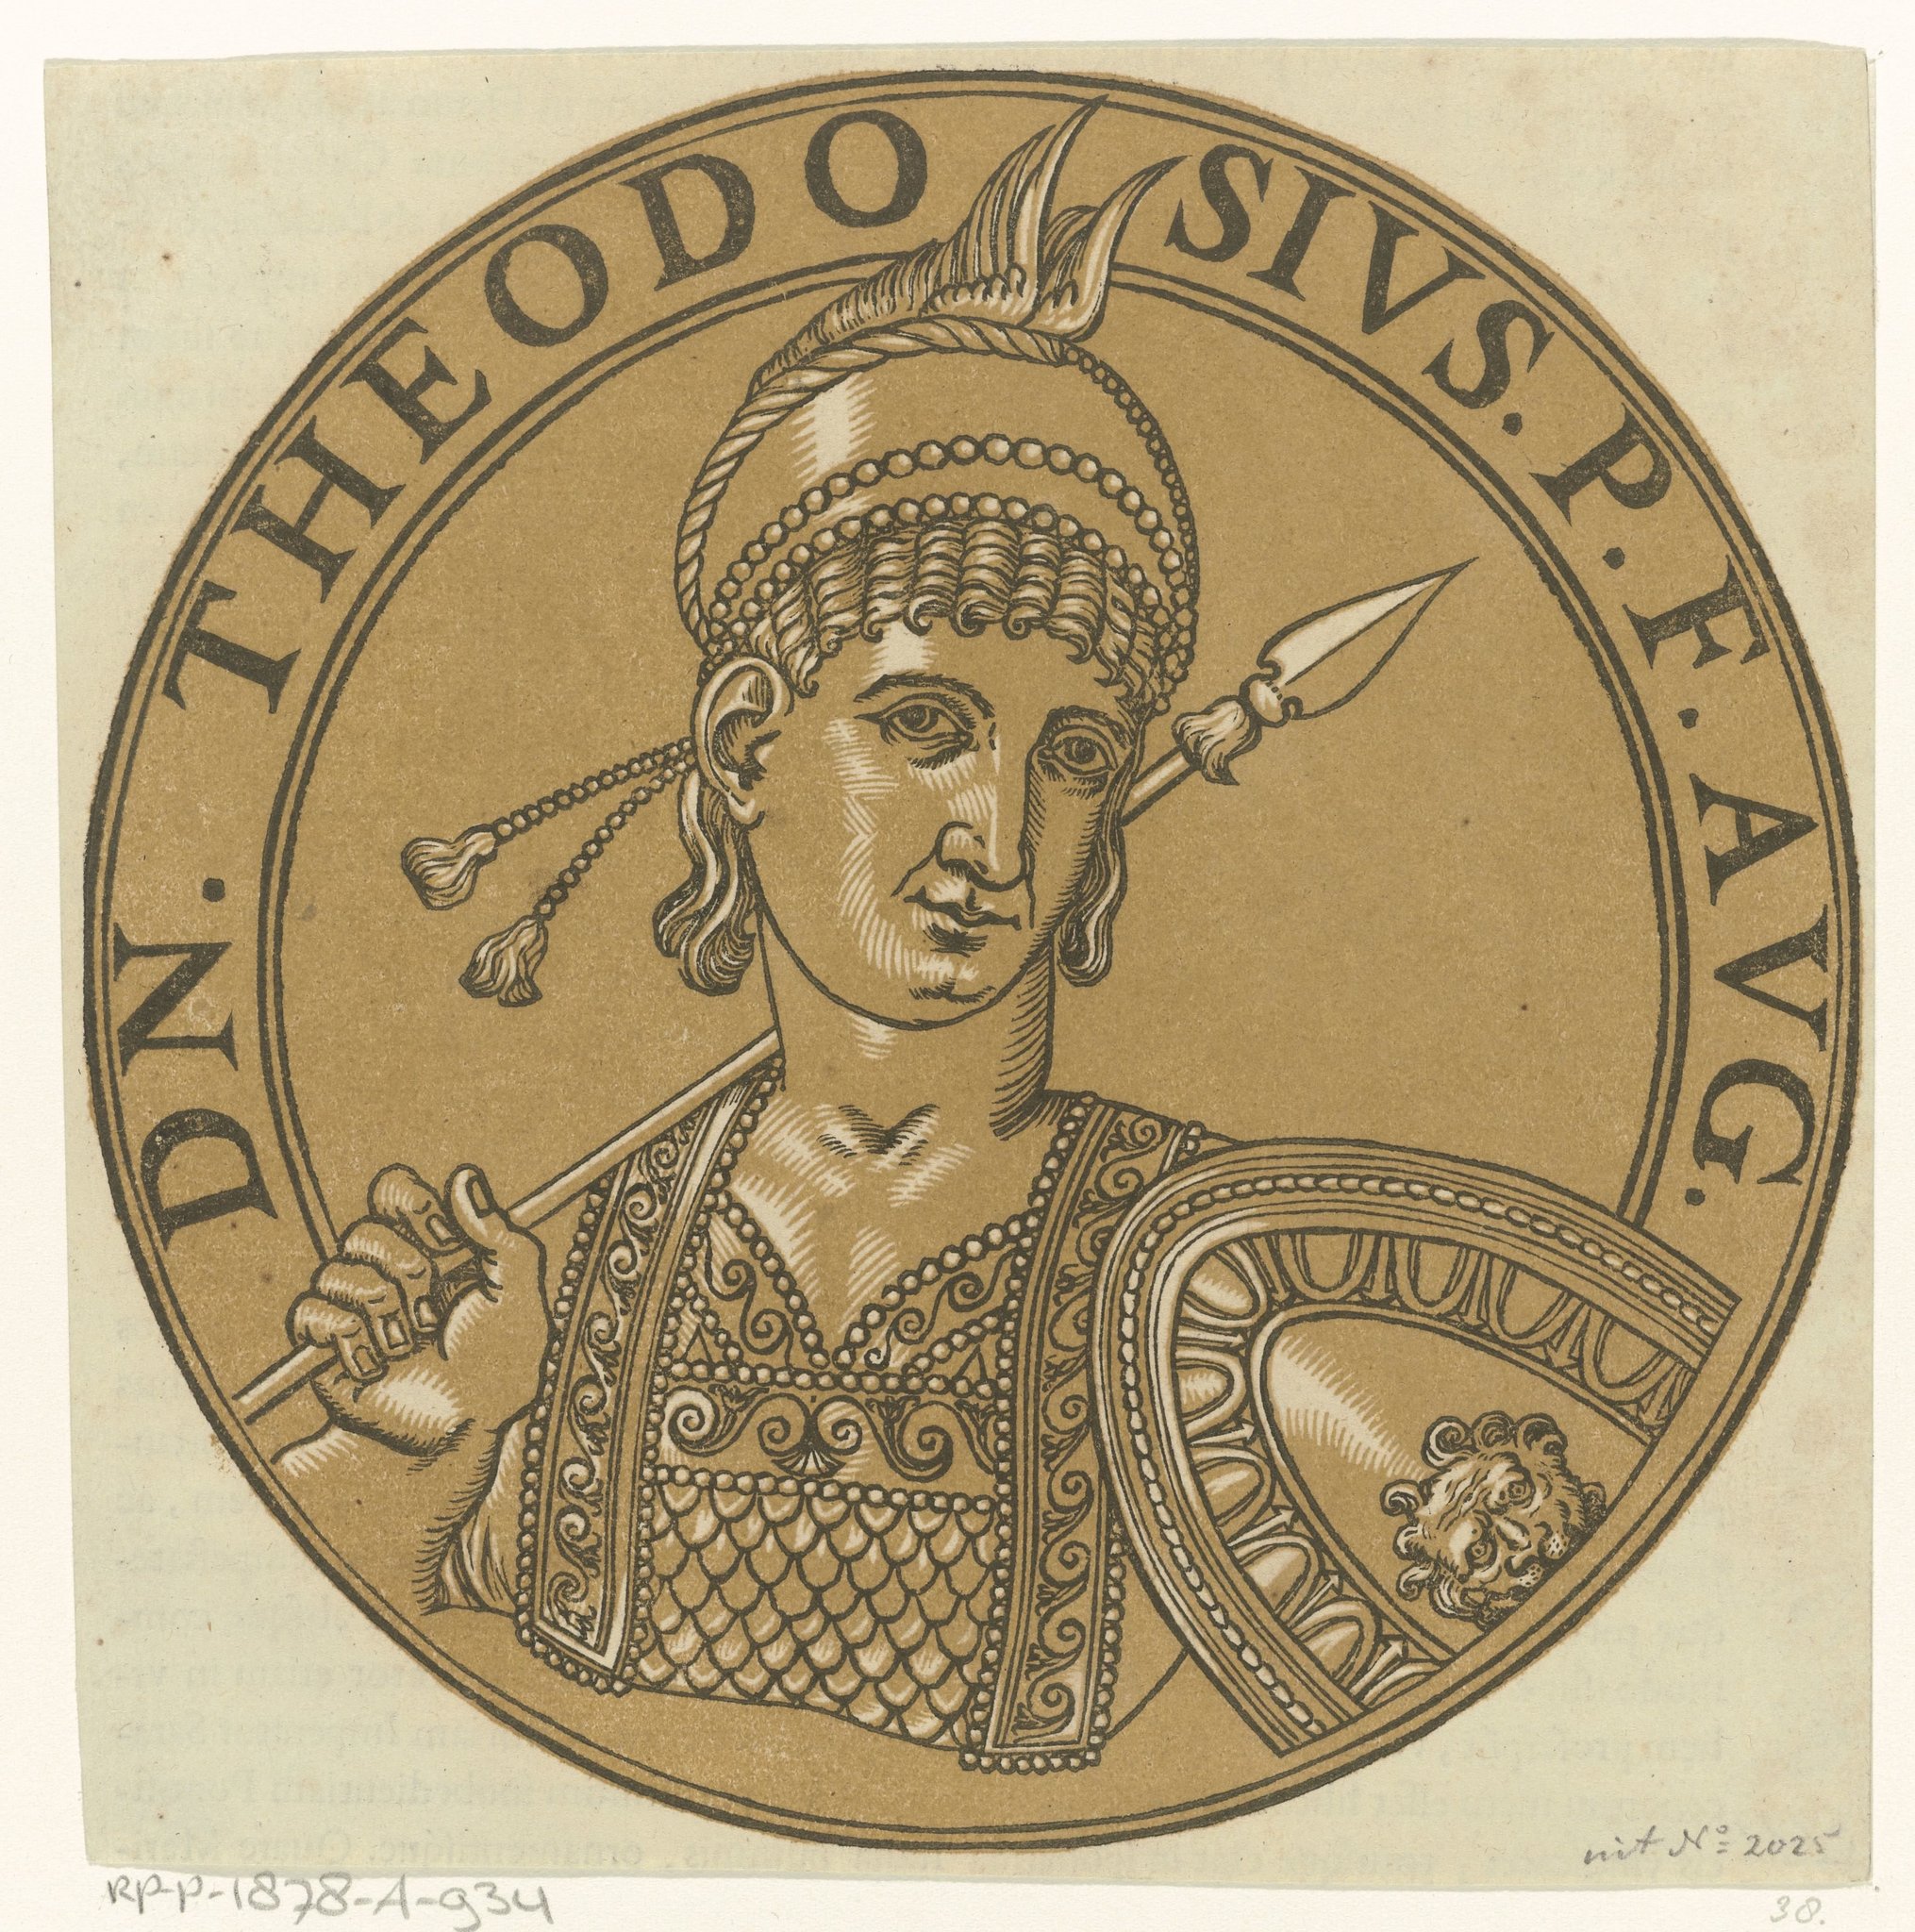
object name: book illustration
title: Icones imperatorum Romanorum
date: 1645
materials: paper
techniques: woodcut, letterpress printing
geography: antwerp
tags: emperor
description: Prent ook gebruikt voor: Icones Imperatorum Romanorum, Antwerpen: Ex officina Plantiniana Balthasaris Moreti, 1645, p. 209. De geportretteerde op de numismatische bron voor dit portret wordt tegenwoordig geïdentificeerd als Theodosius II, niet als Theodosius III. De begeleidende tekst en de locatie in het boek van het voorbeeld door Goltzius verwijzen echter naar het leven van Theodosius III, vandaar dat voor deze titel gekozen is.